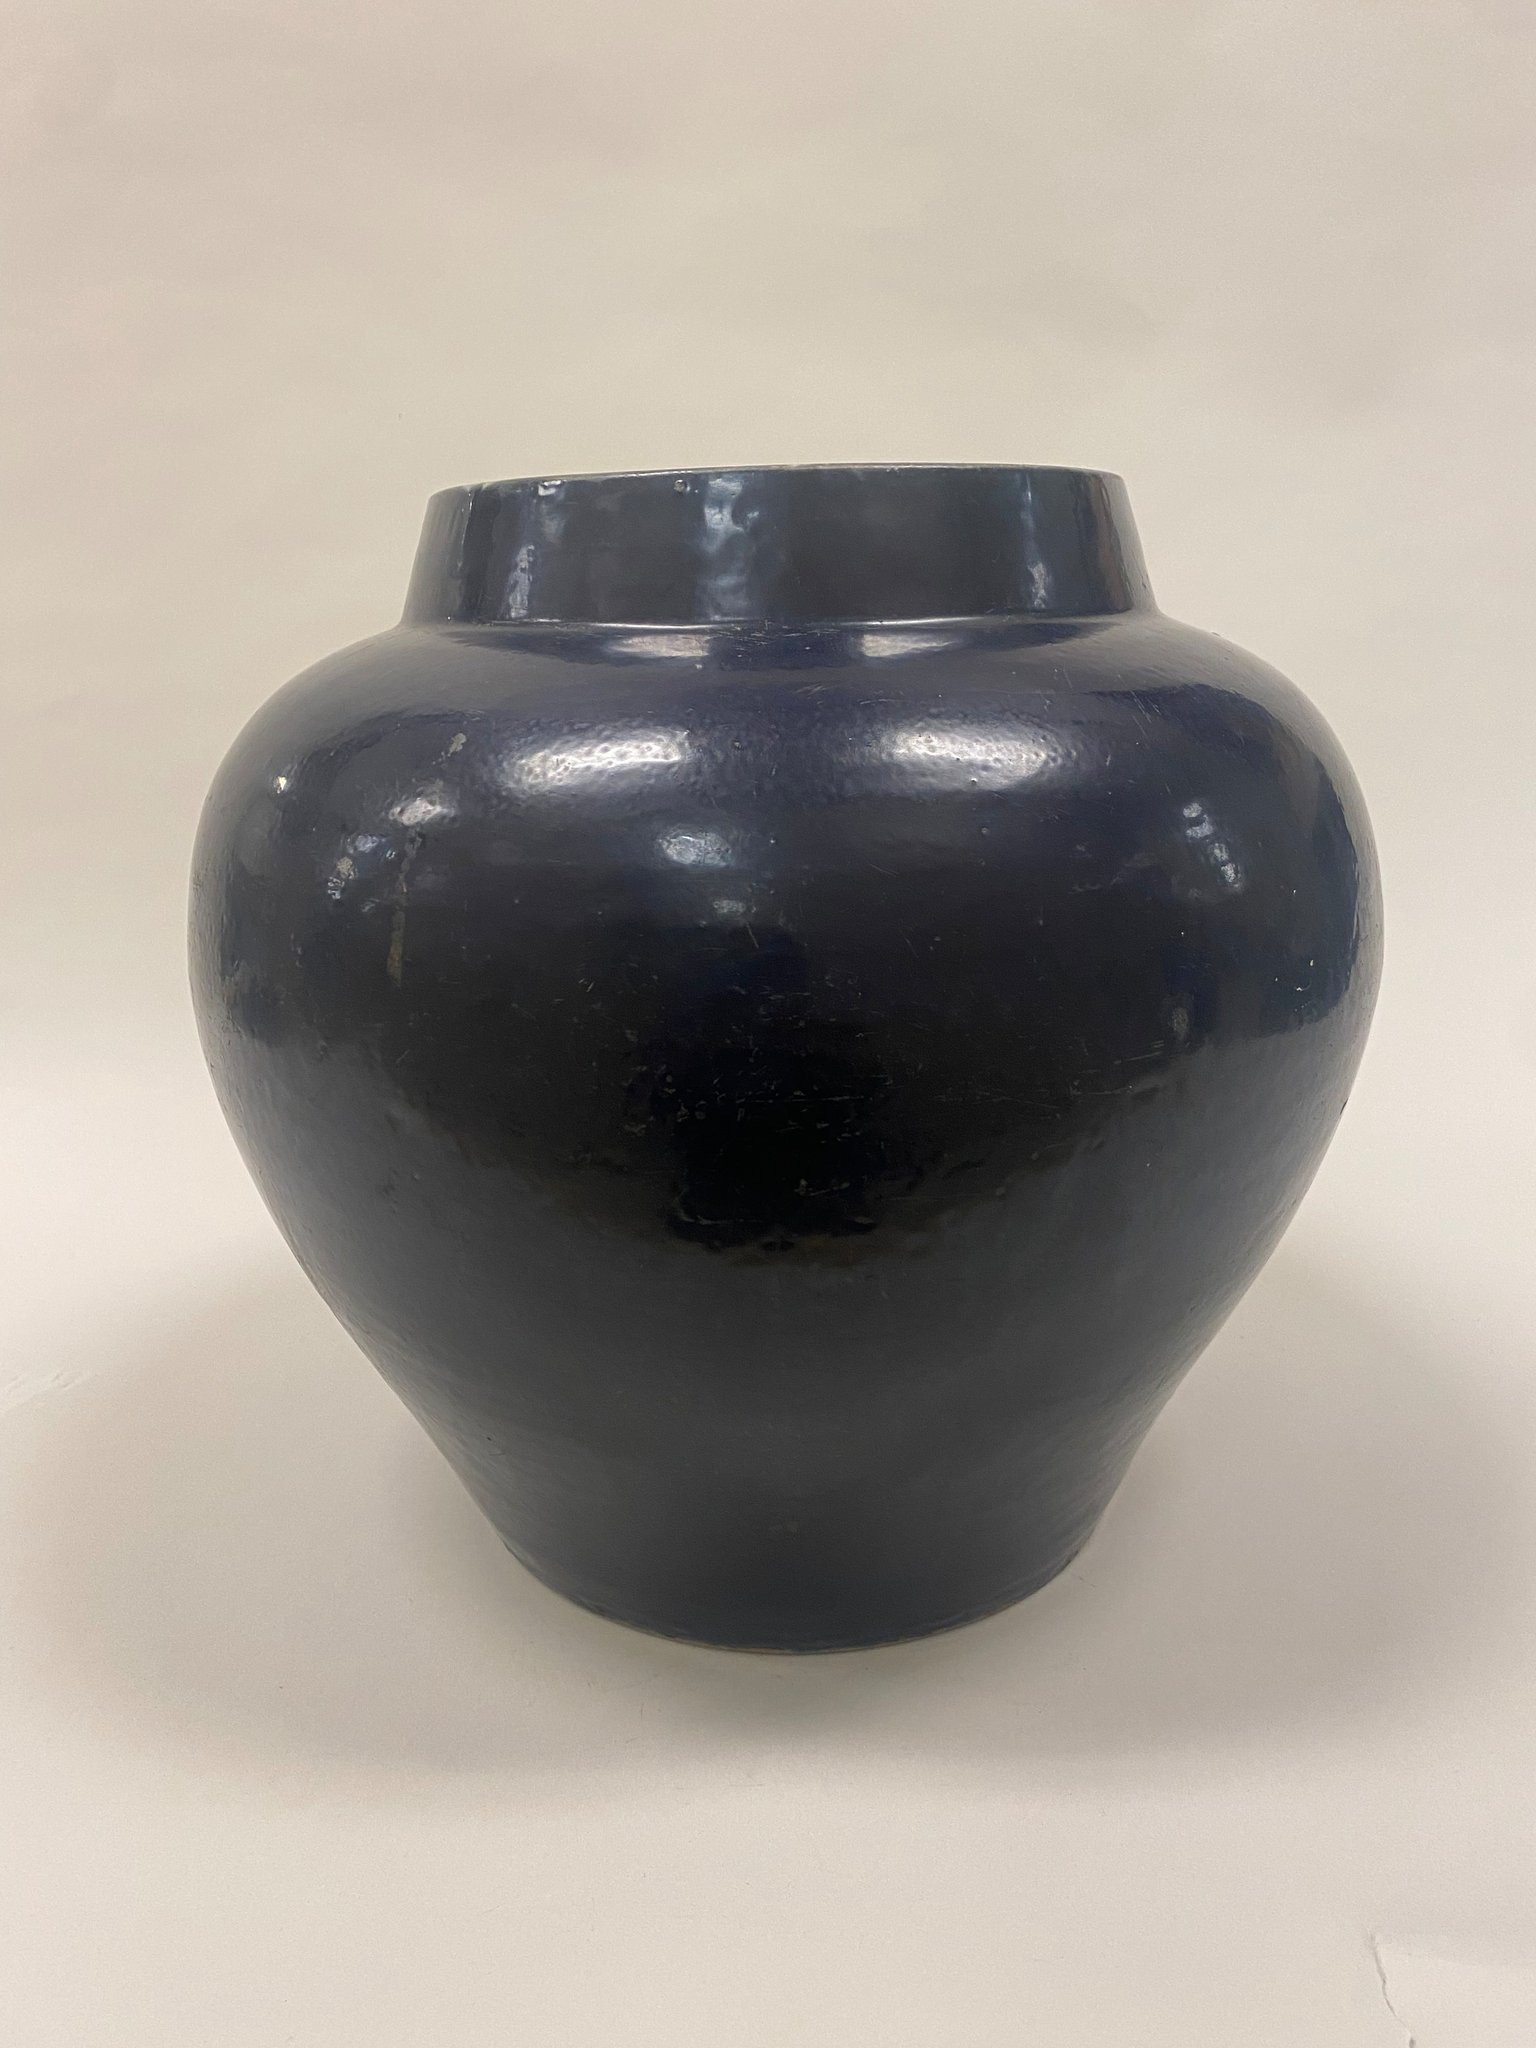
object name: jar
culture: chinese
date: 1401-1600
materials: glaze, stoneware